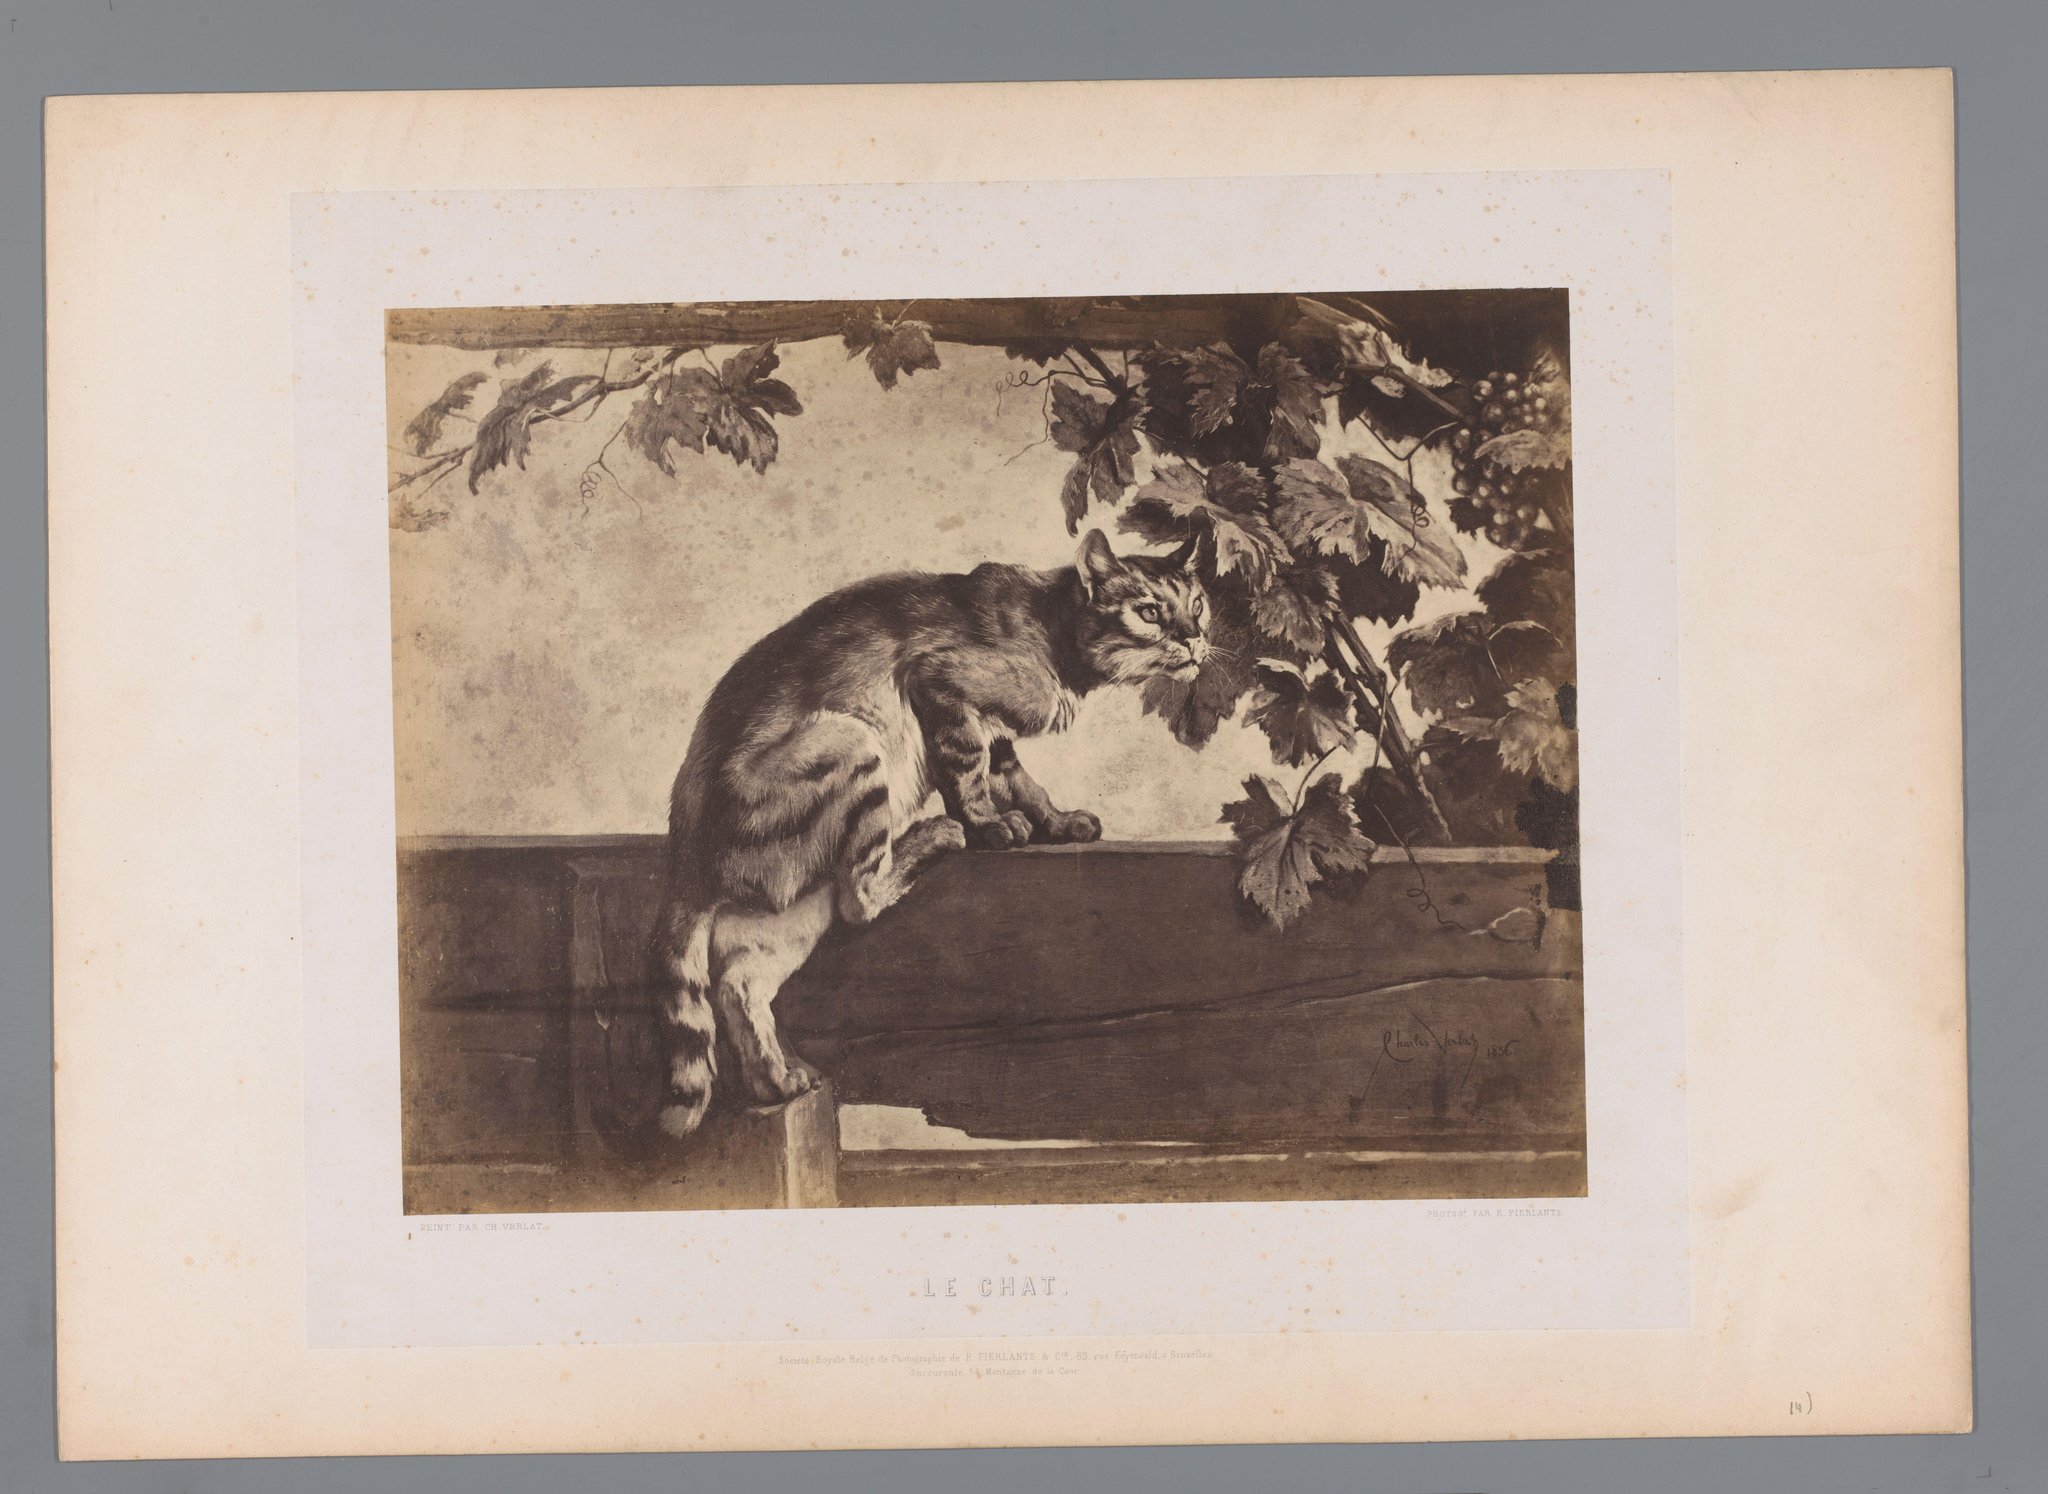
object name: photograph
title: Le Chat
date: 1858-1863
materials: photographic support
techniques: albumen print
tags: cat, fence, wall, paling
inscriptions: number: ‘14)’, inscription: ‘Société Royal Belge de Photographie. E. Fierlants et Cie., 69, rue Keyenveld, à Bruxelles./ Succursale, 54, Montagne de la Cour, à Bruxelles.’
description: Deze foto maakt deel uit van een omslag met zeven foto's, twee titelbladen en een lijst van afbeeldingen.